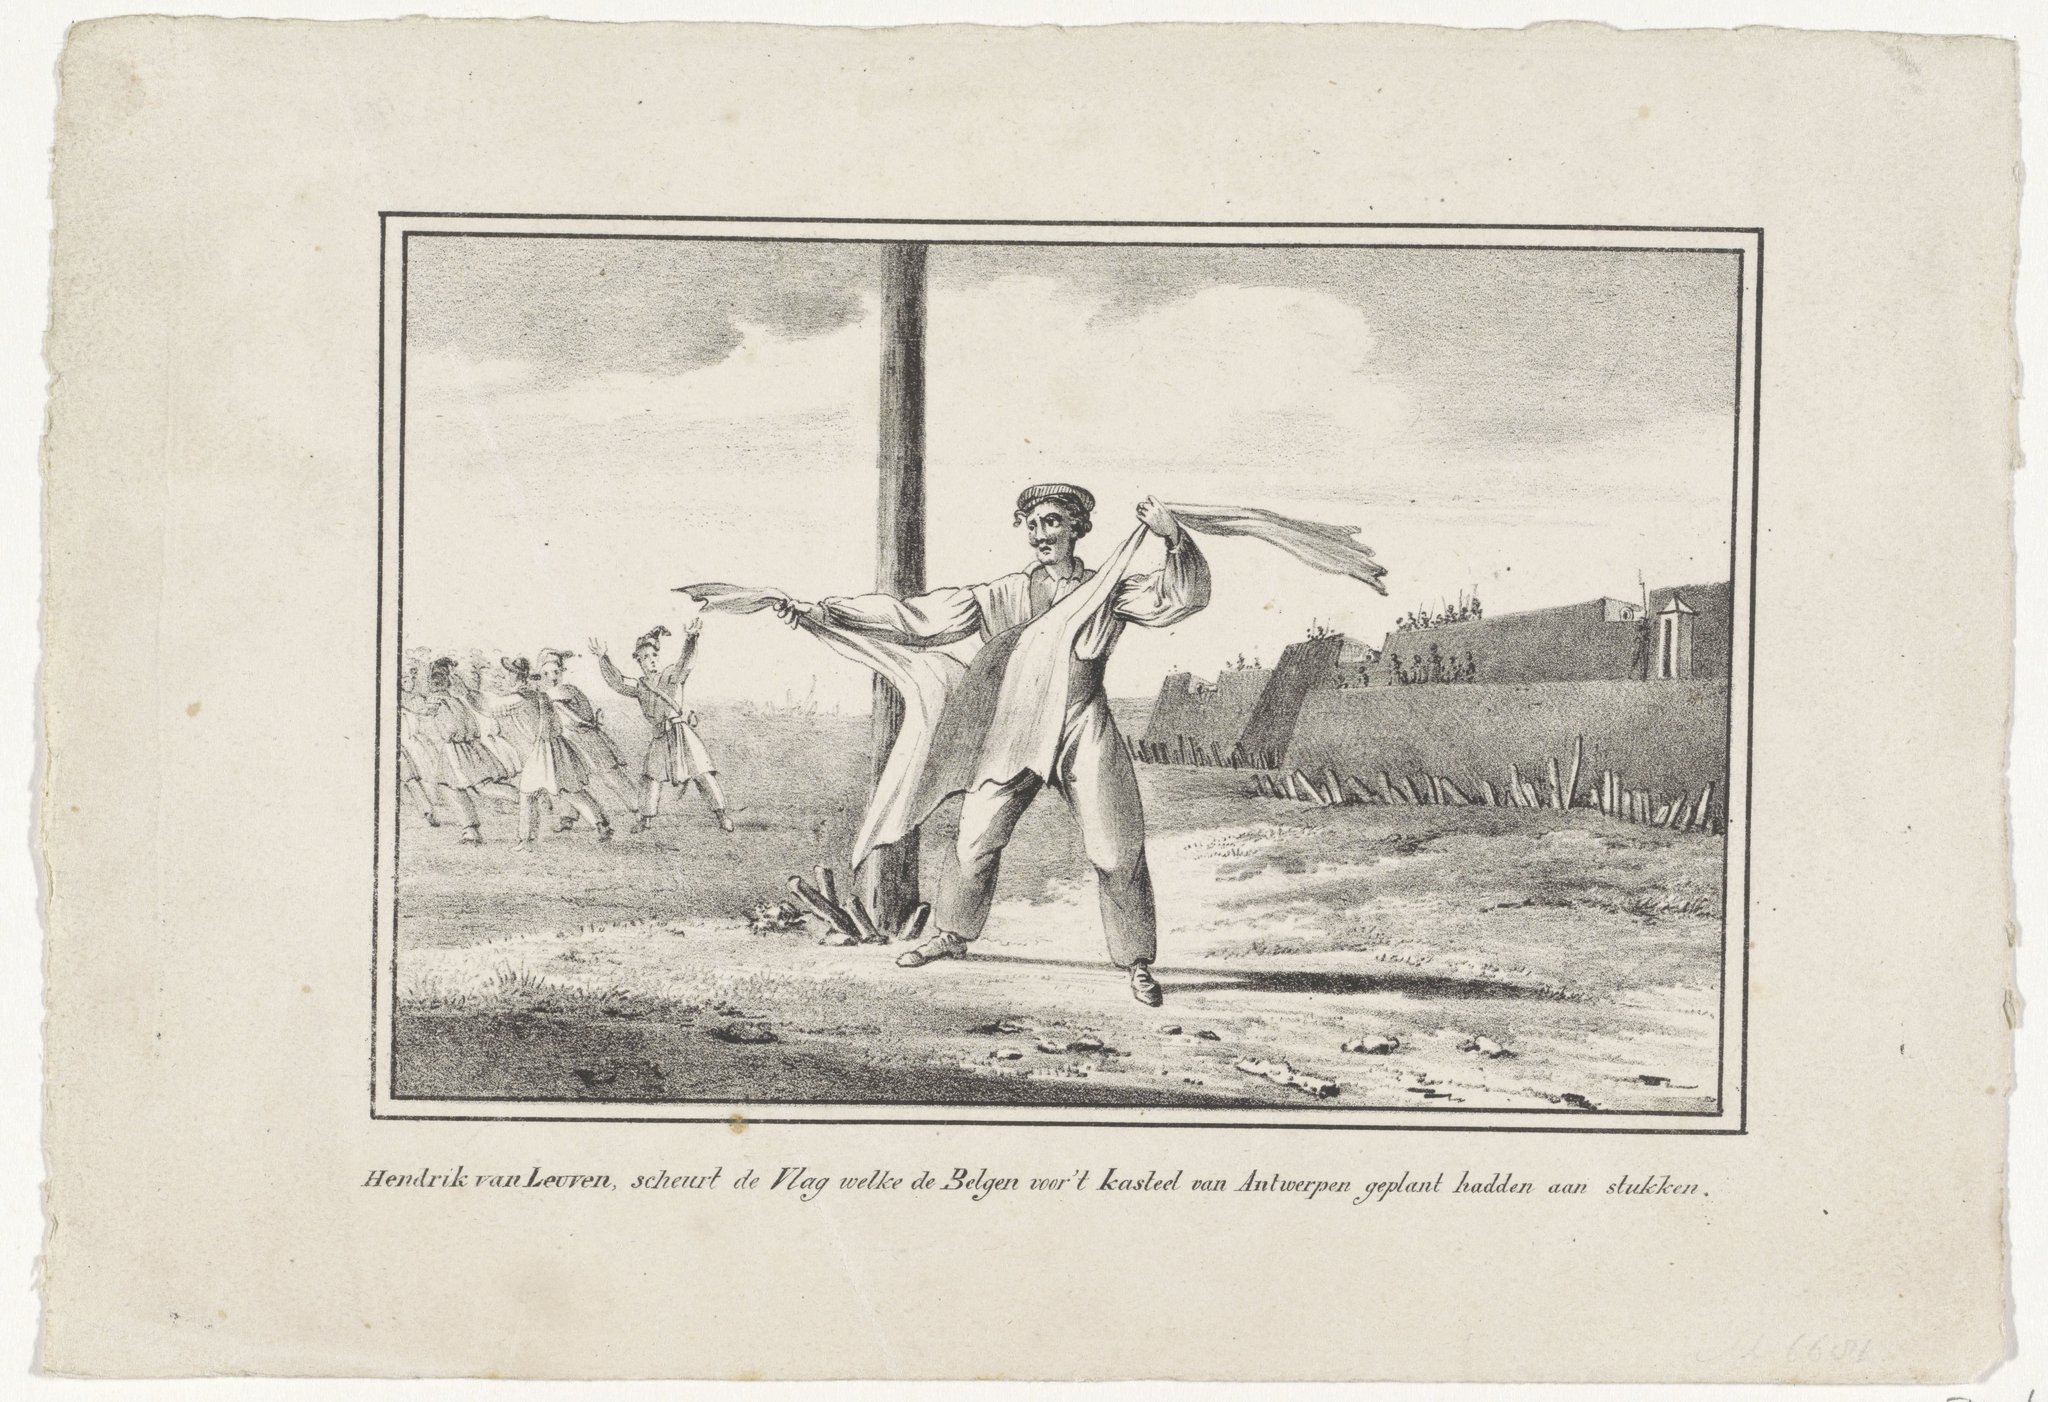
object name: print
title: Hendrik van Leuven, scheurt de Vlag welke de Belgen voor 't kasteel van Antwerpen geplant hadden aan stukken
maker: Anonymous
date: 1831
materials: paper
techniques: lithograph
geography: netherlands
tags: amsterdam, flag, colours (as symbol of the state, etc.)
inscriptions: collector's mark: Lugt 2228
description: De Nederlandse fuselier Hendrik van Leuven verscheurt met zijn handen de Belgische vlag die door de Belgen voor de Citadel van Antwerpen was geplaatst, 26 mei 1831.